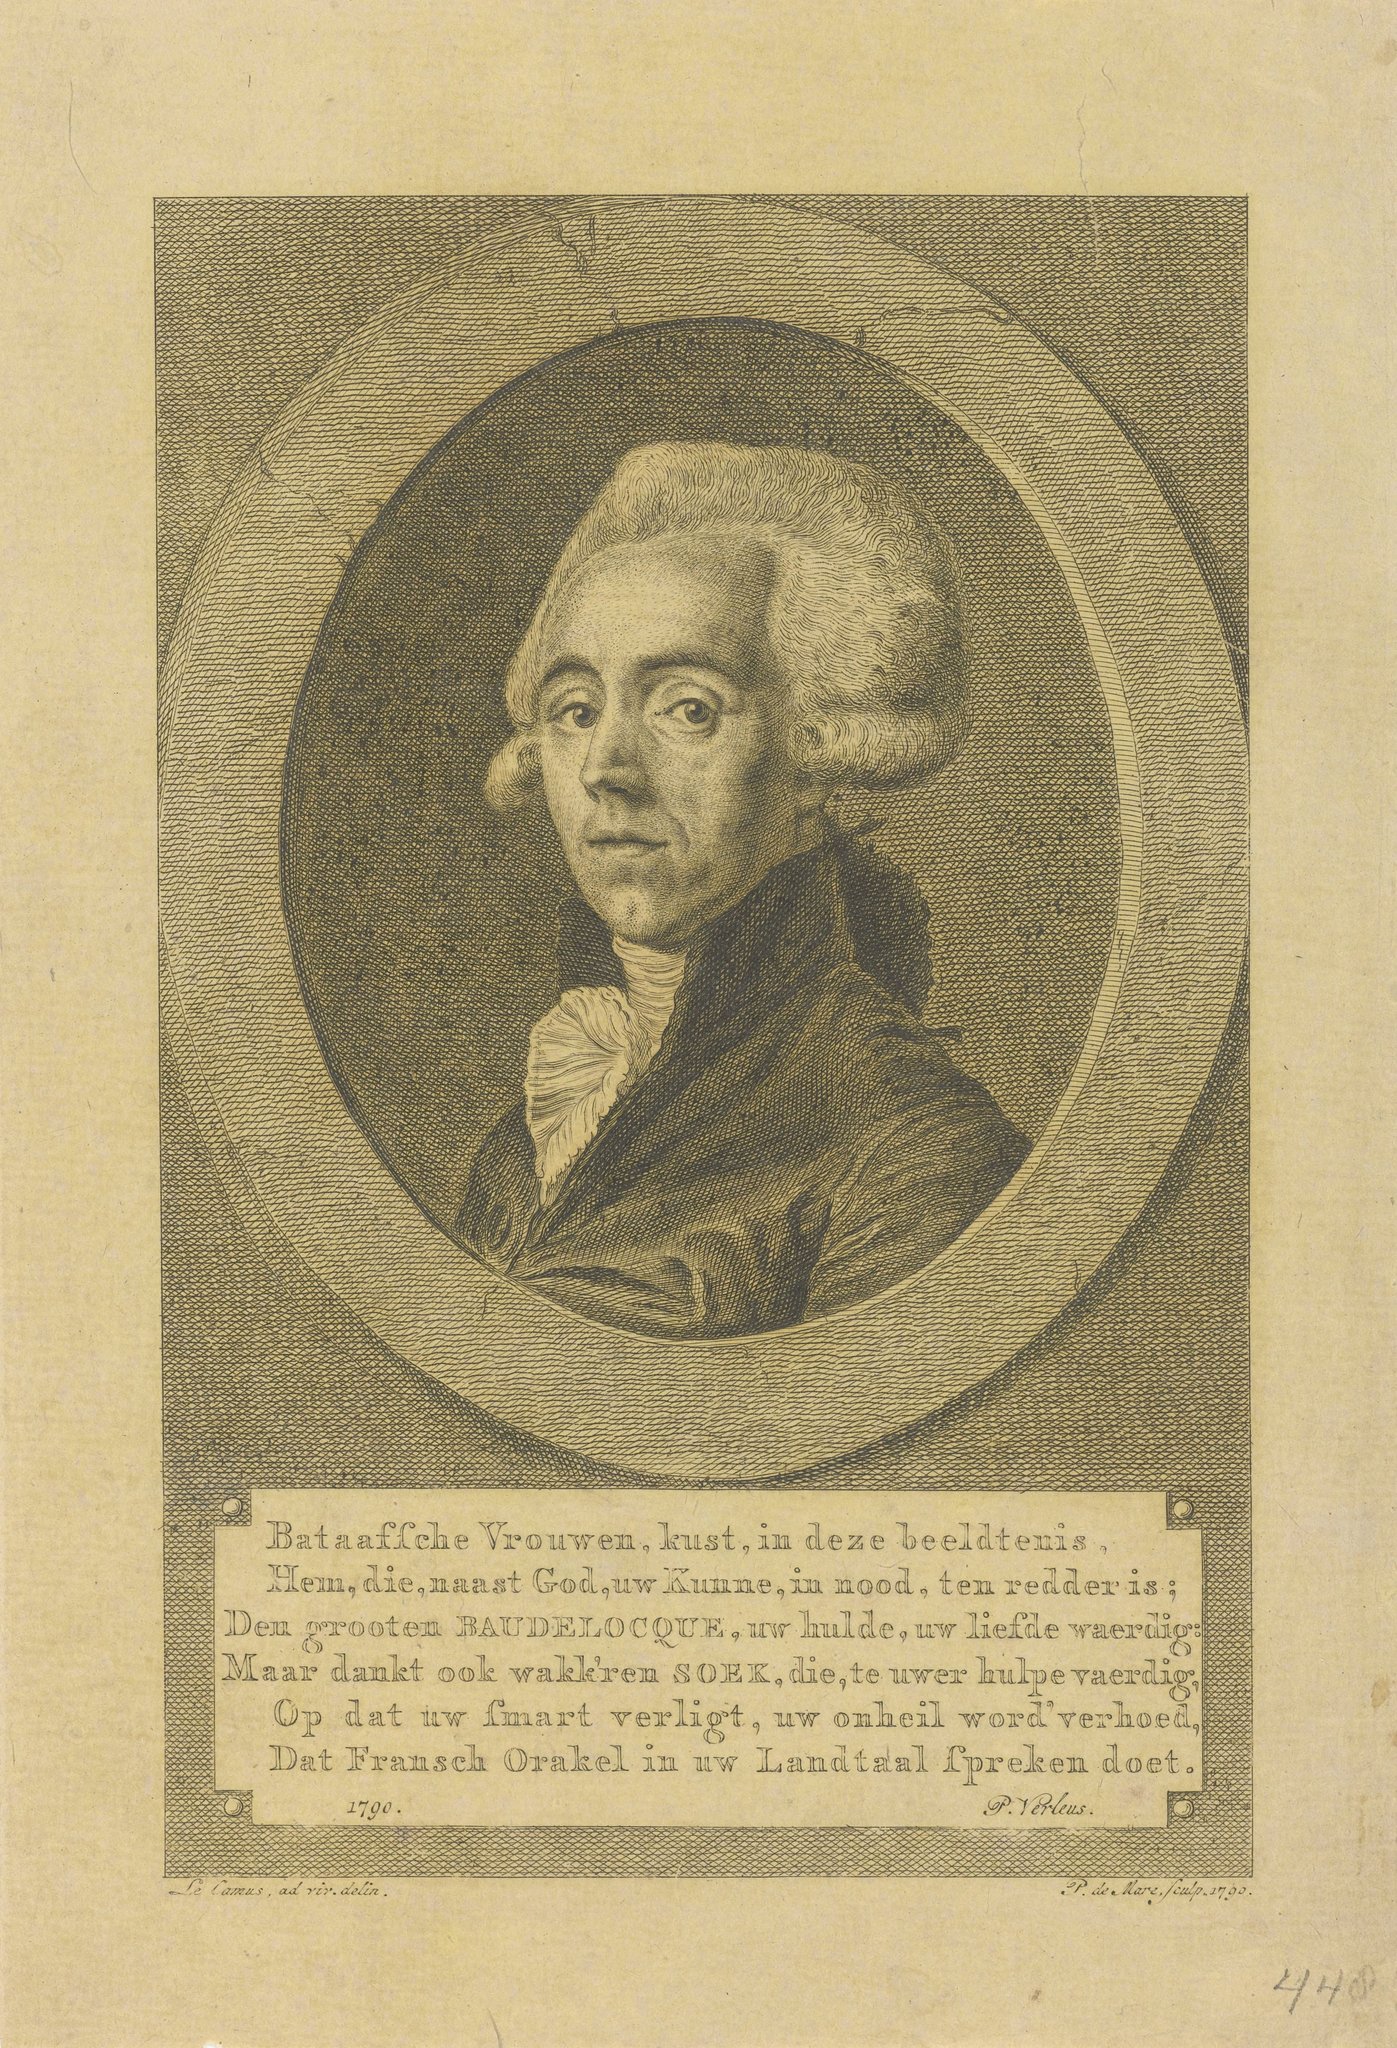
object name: print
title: Portret van Jean-Louis Baudelocque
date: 1790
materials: paper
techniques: engraving, etching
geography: leiden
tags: verloskundige, arts, jean-louis baudelocque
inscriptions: collector's mark: Lugt 2228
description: Portret van de verloskundige Jean-Louis Baudelocque.